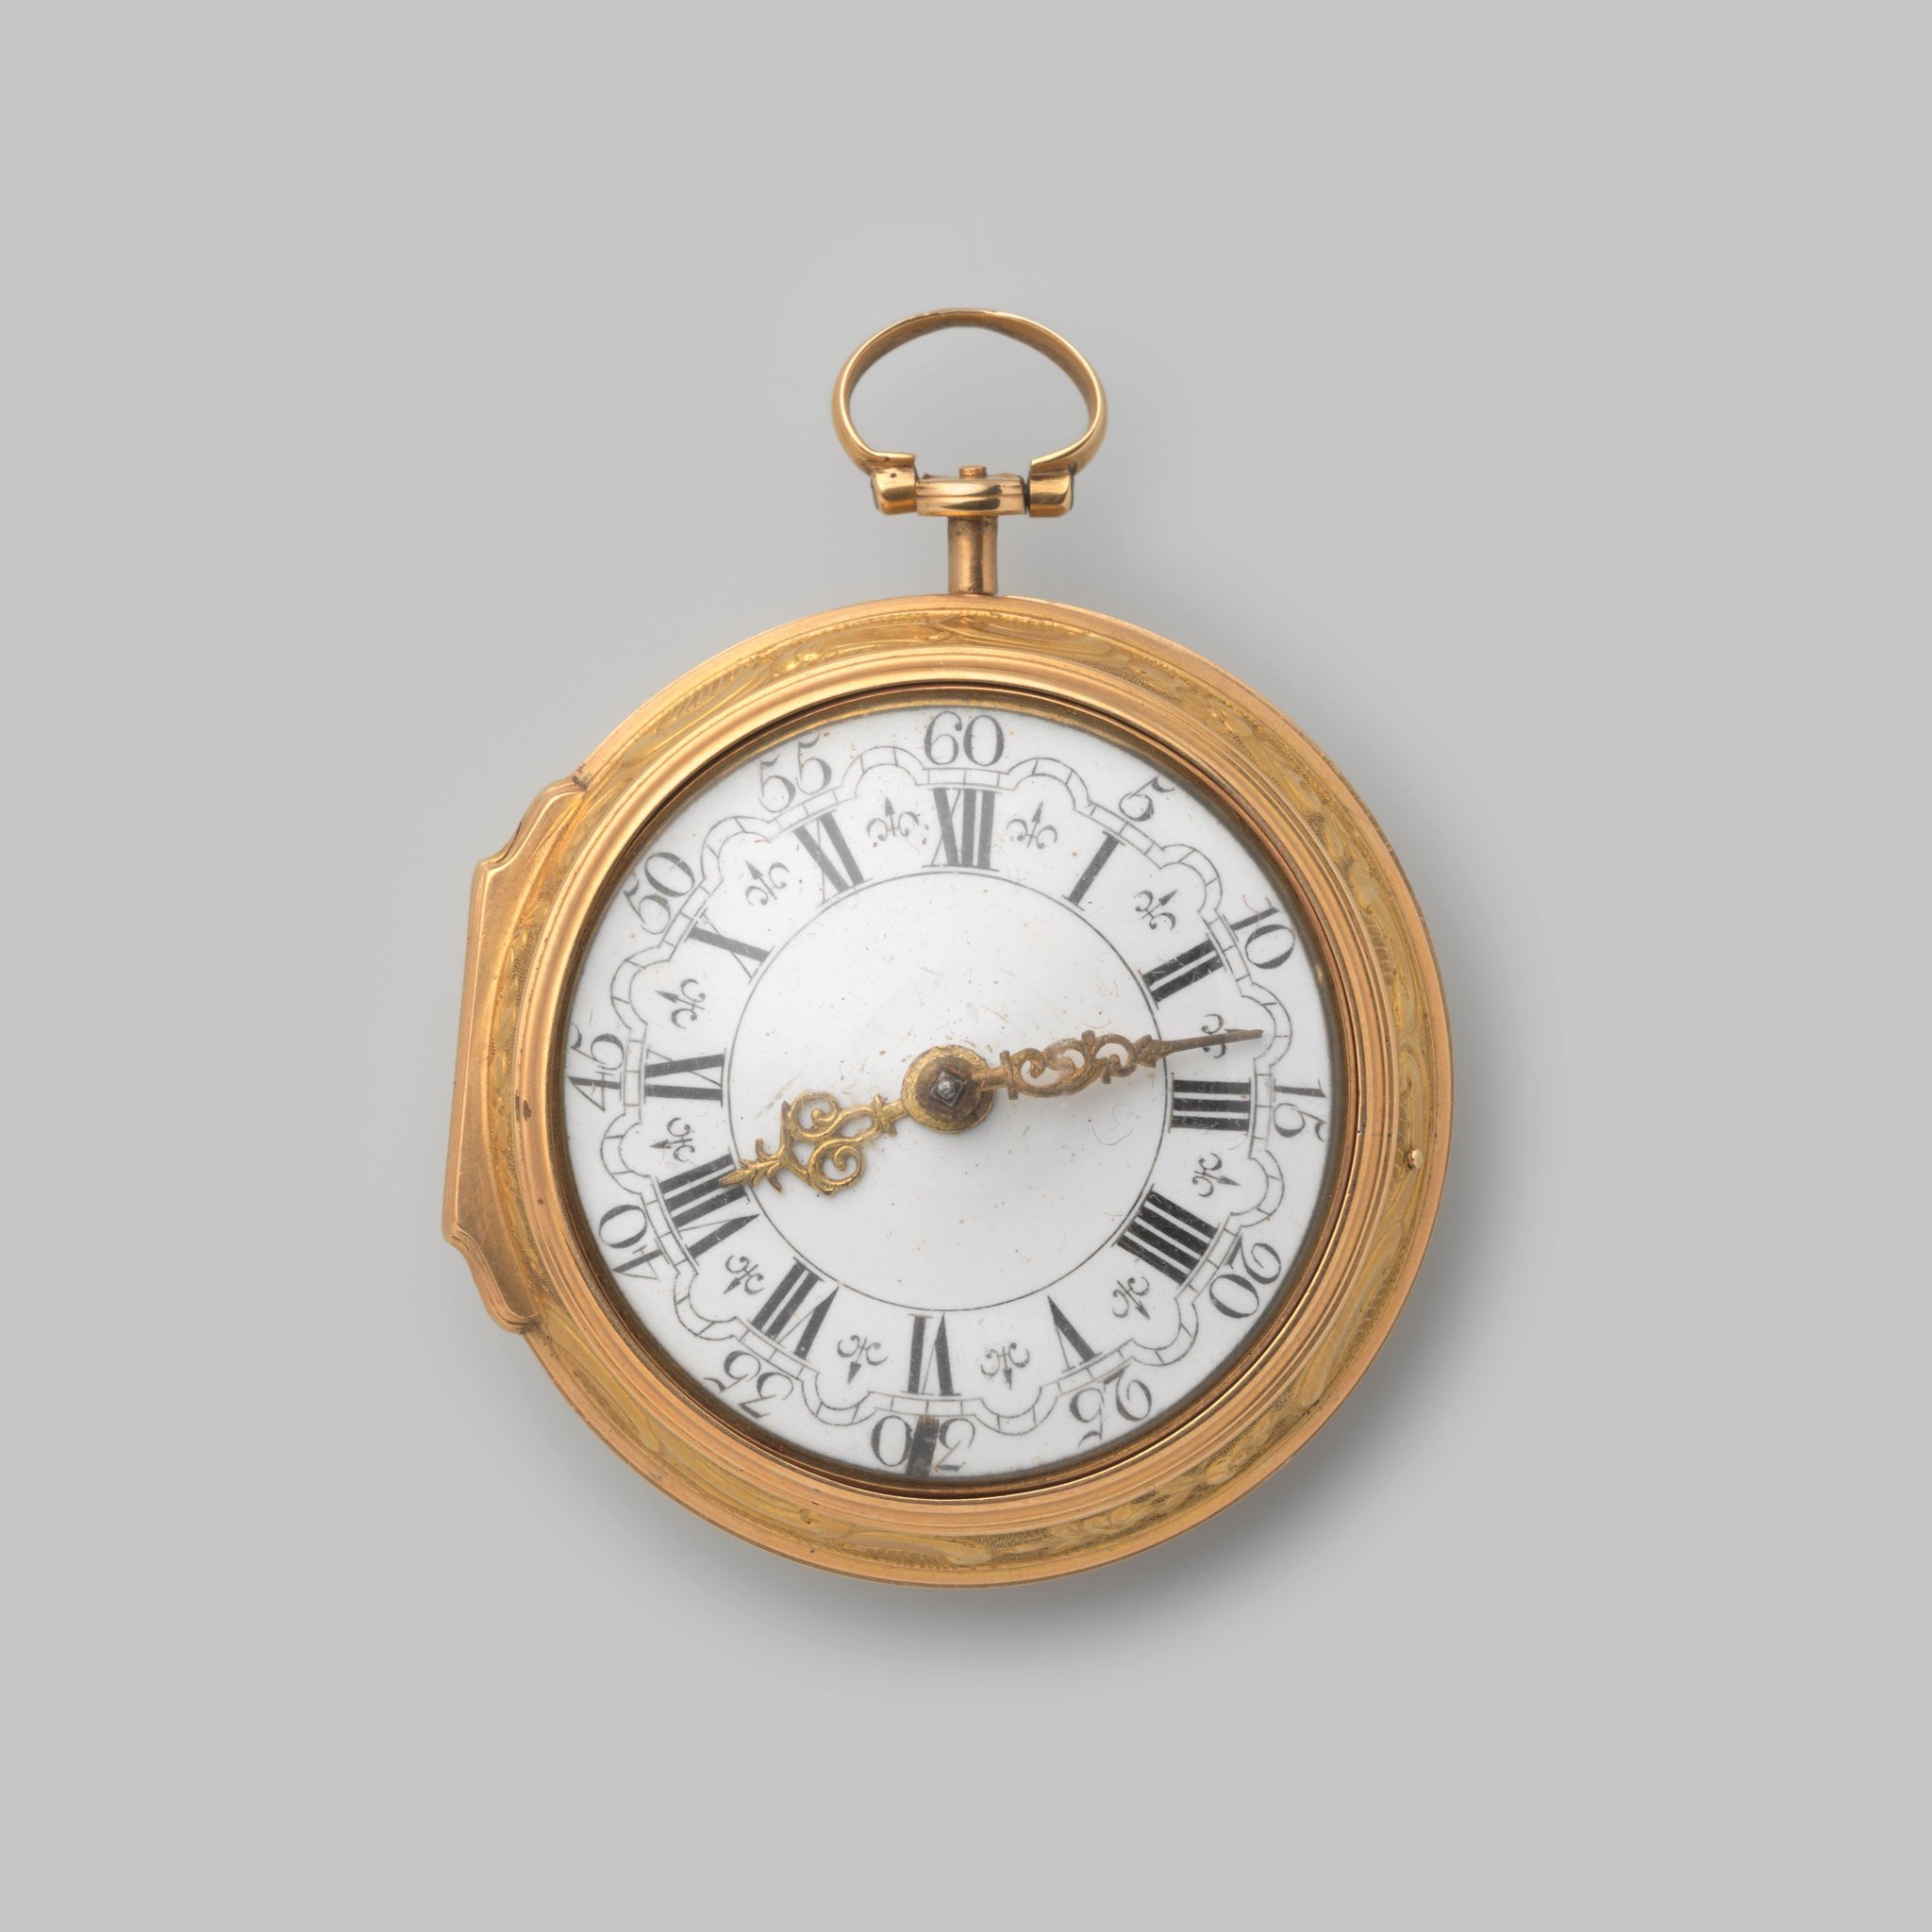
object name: wrist watch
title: Horloge van goud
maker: grand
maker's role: horlogemaker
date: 1762-1763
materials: gold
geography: london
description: Gouden horloge met geëmailleerde wijzerplaat. In de buitenkast is een voorstelling gedreven van een man die een orakel raadpleegt (Aeneas).